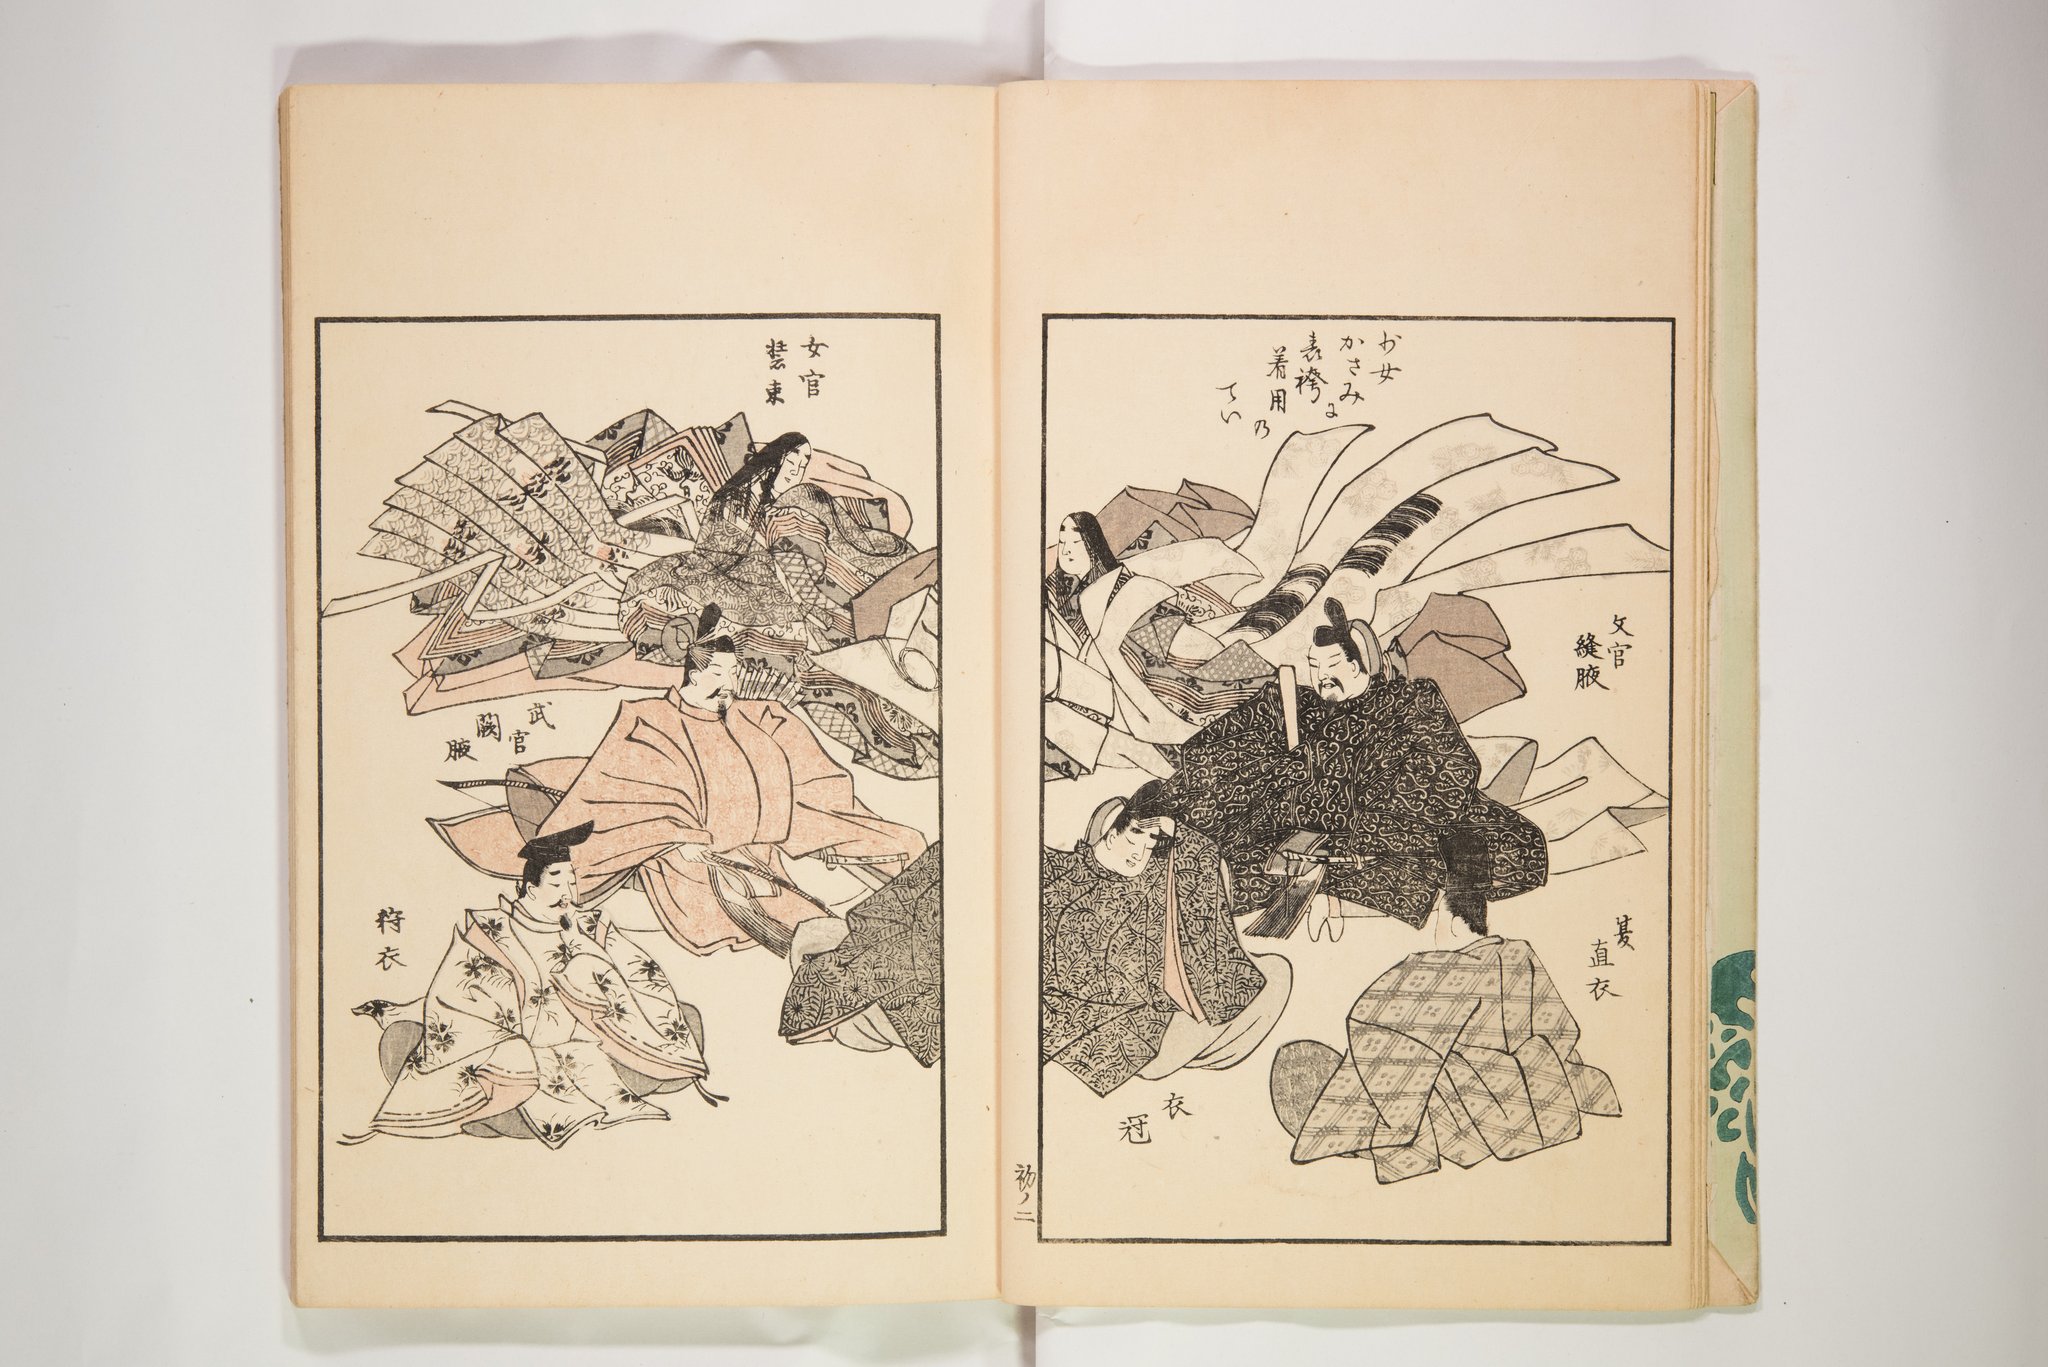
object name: illustrated book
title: Chiyomigusa (Book on Design) ちよみくさ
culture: japanese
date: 1901